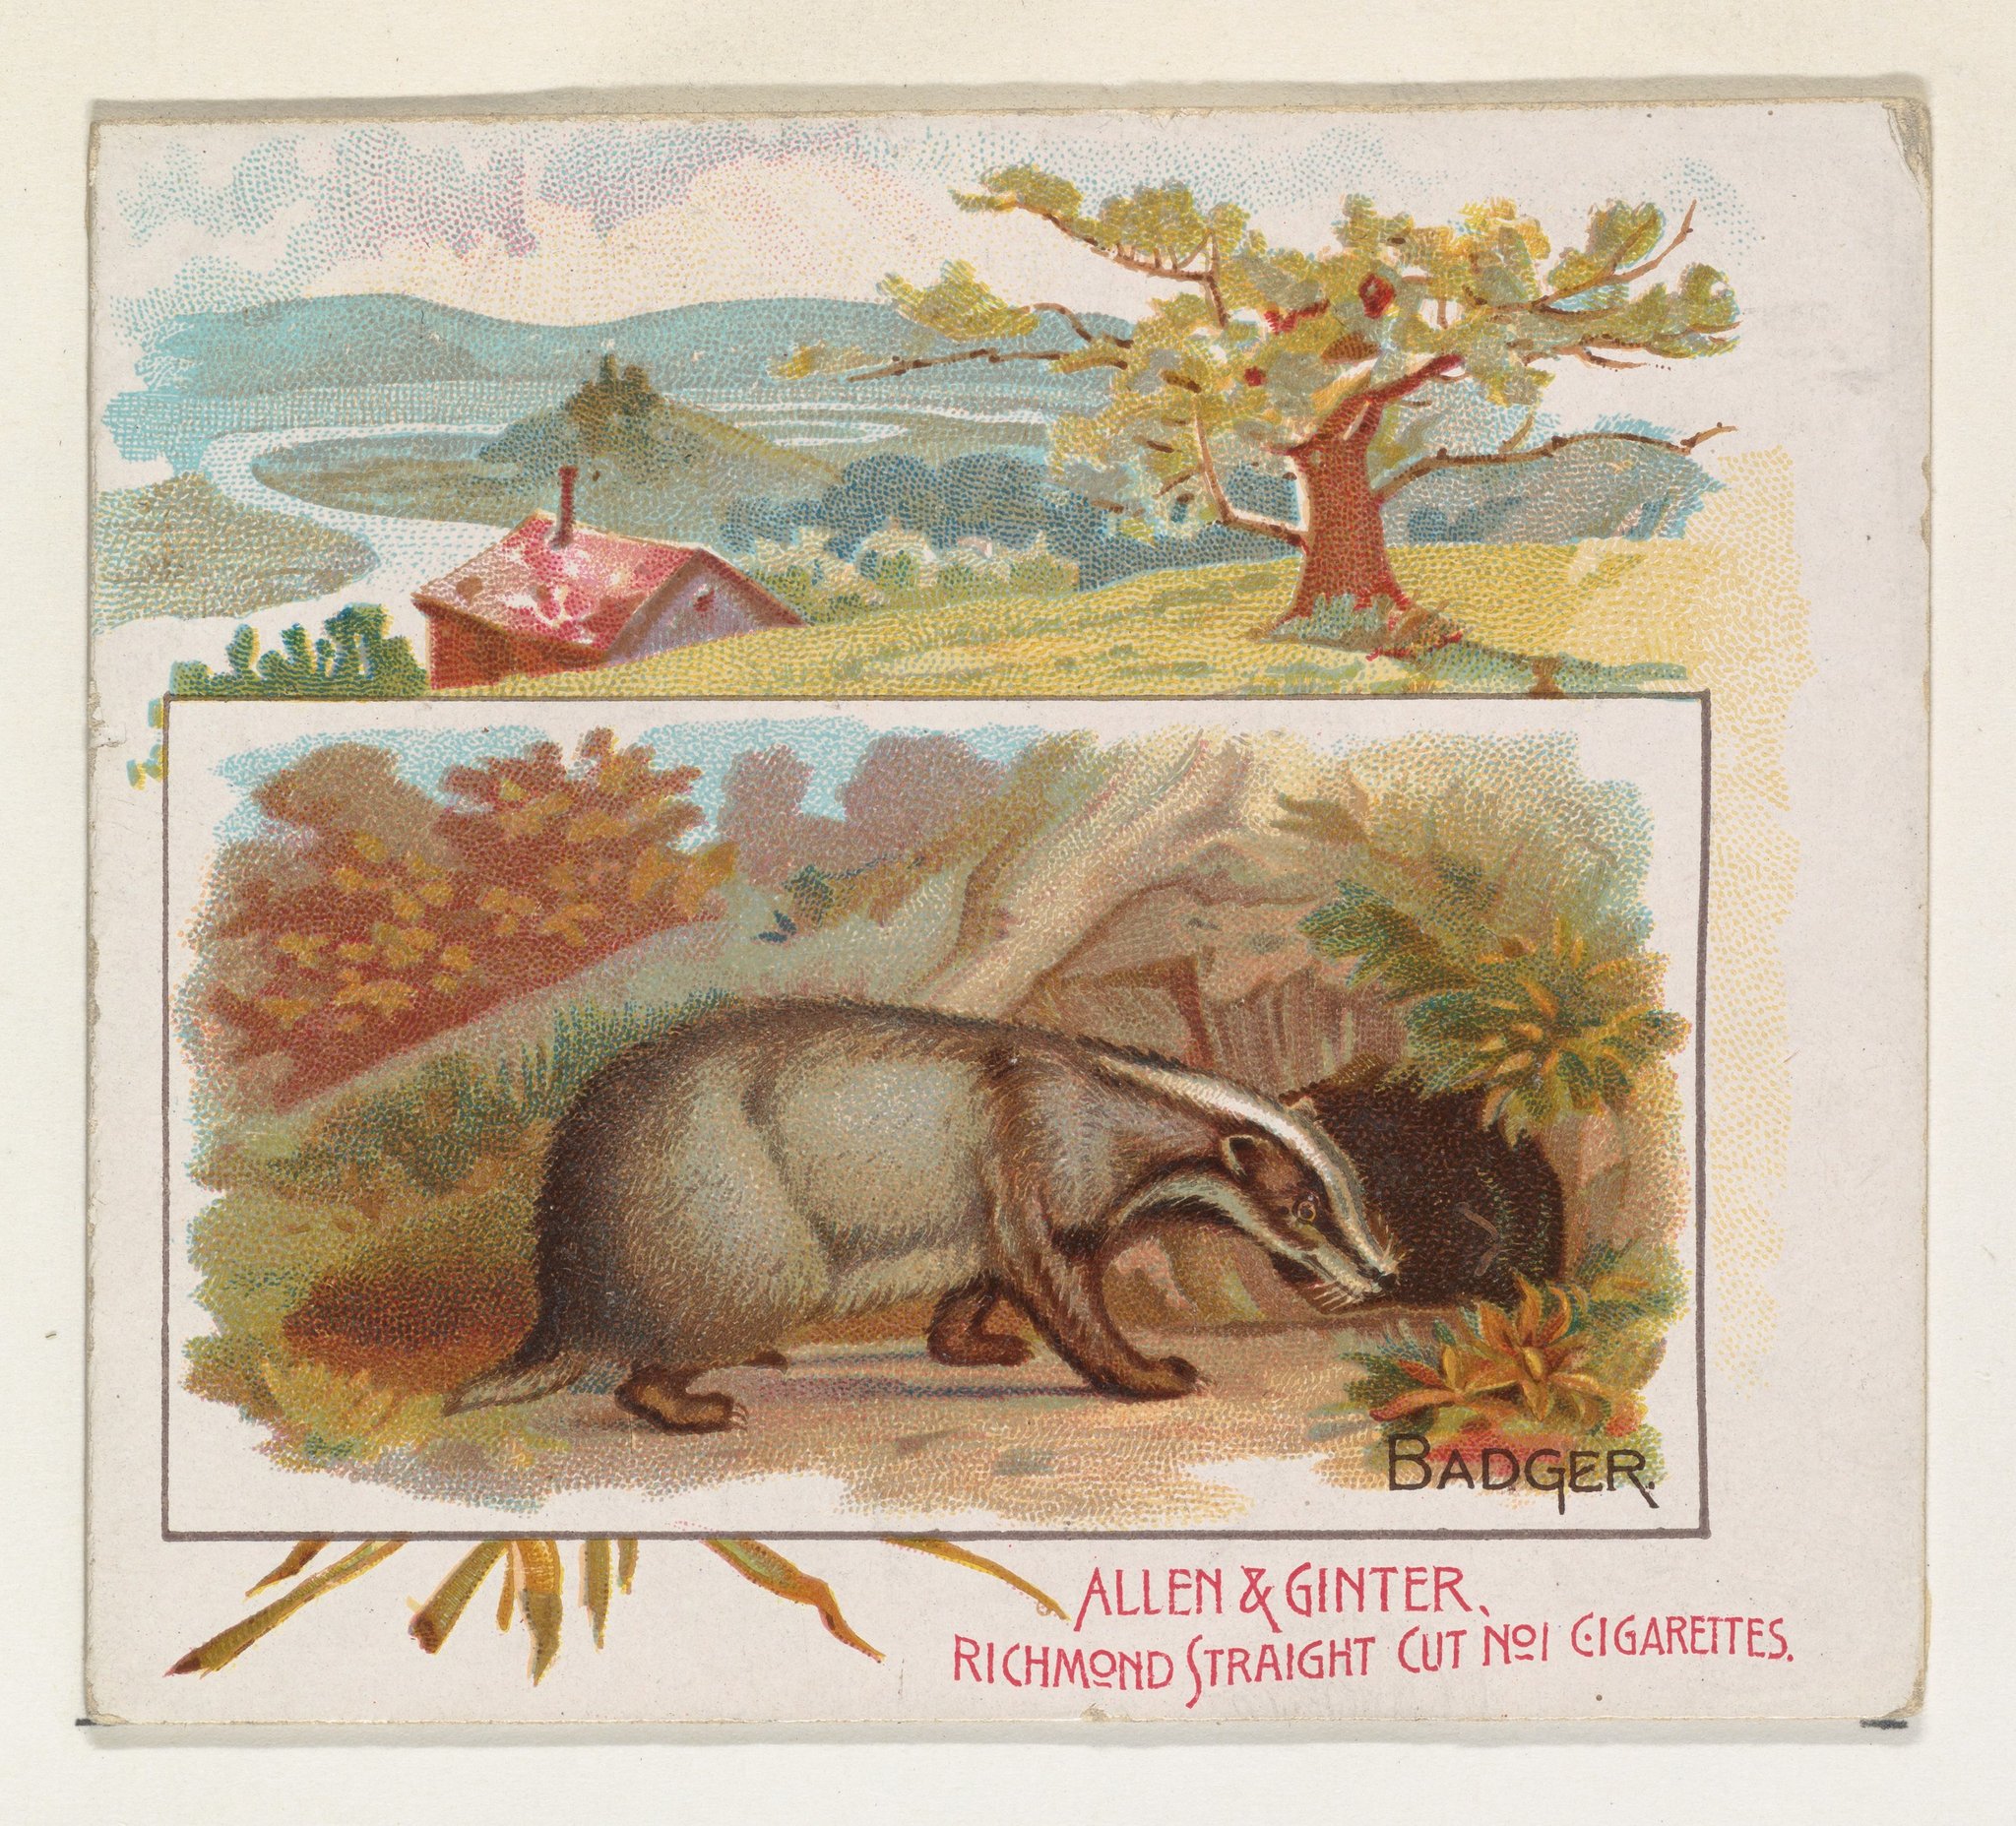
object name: print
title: Badger, from Quadrupeds series (N41) for Allen & Ginter Cigarettes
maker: allen & ginter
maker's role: publisher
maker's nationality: american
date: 1890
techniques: color lithograph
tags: animals